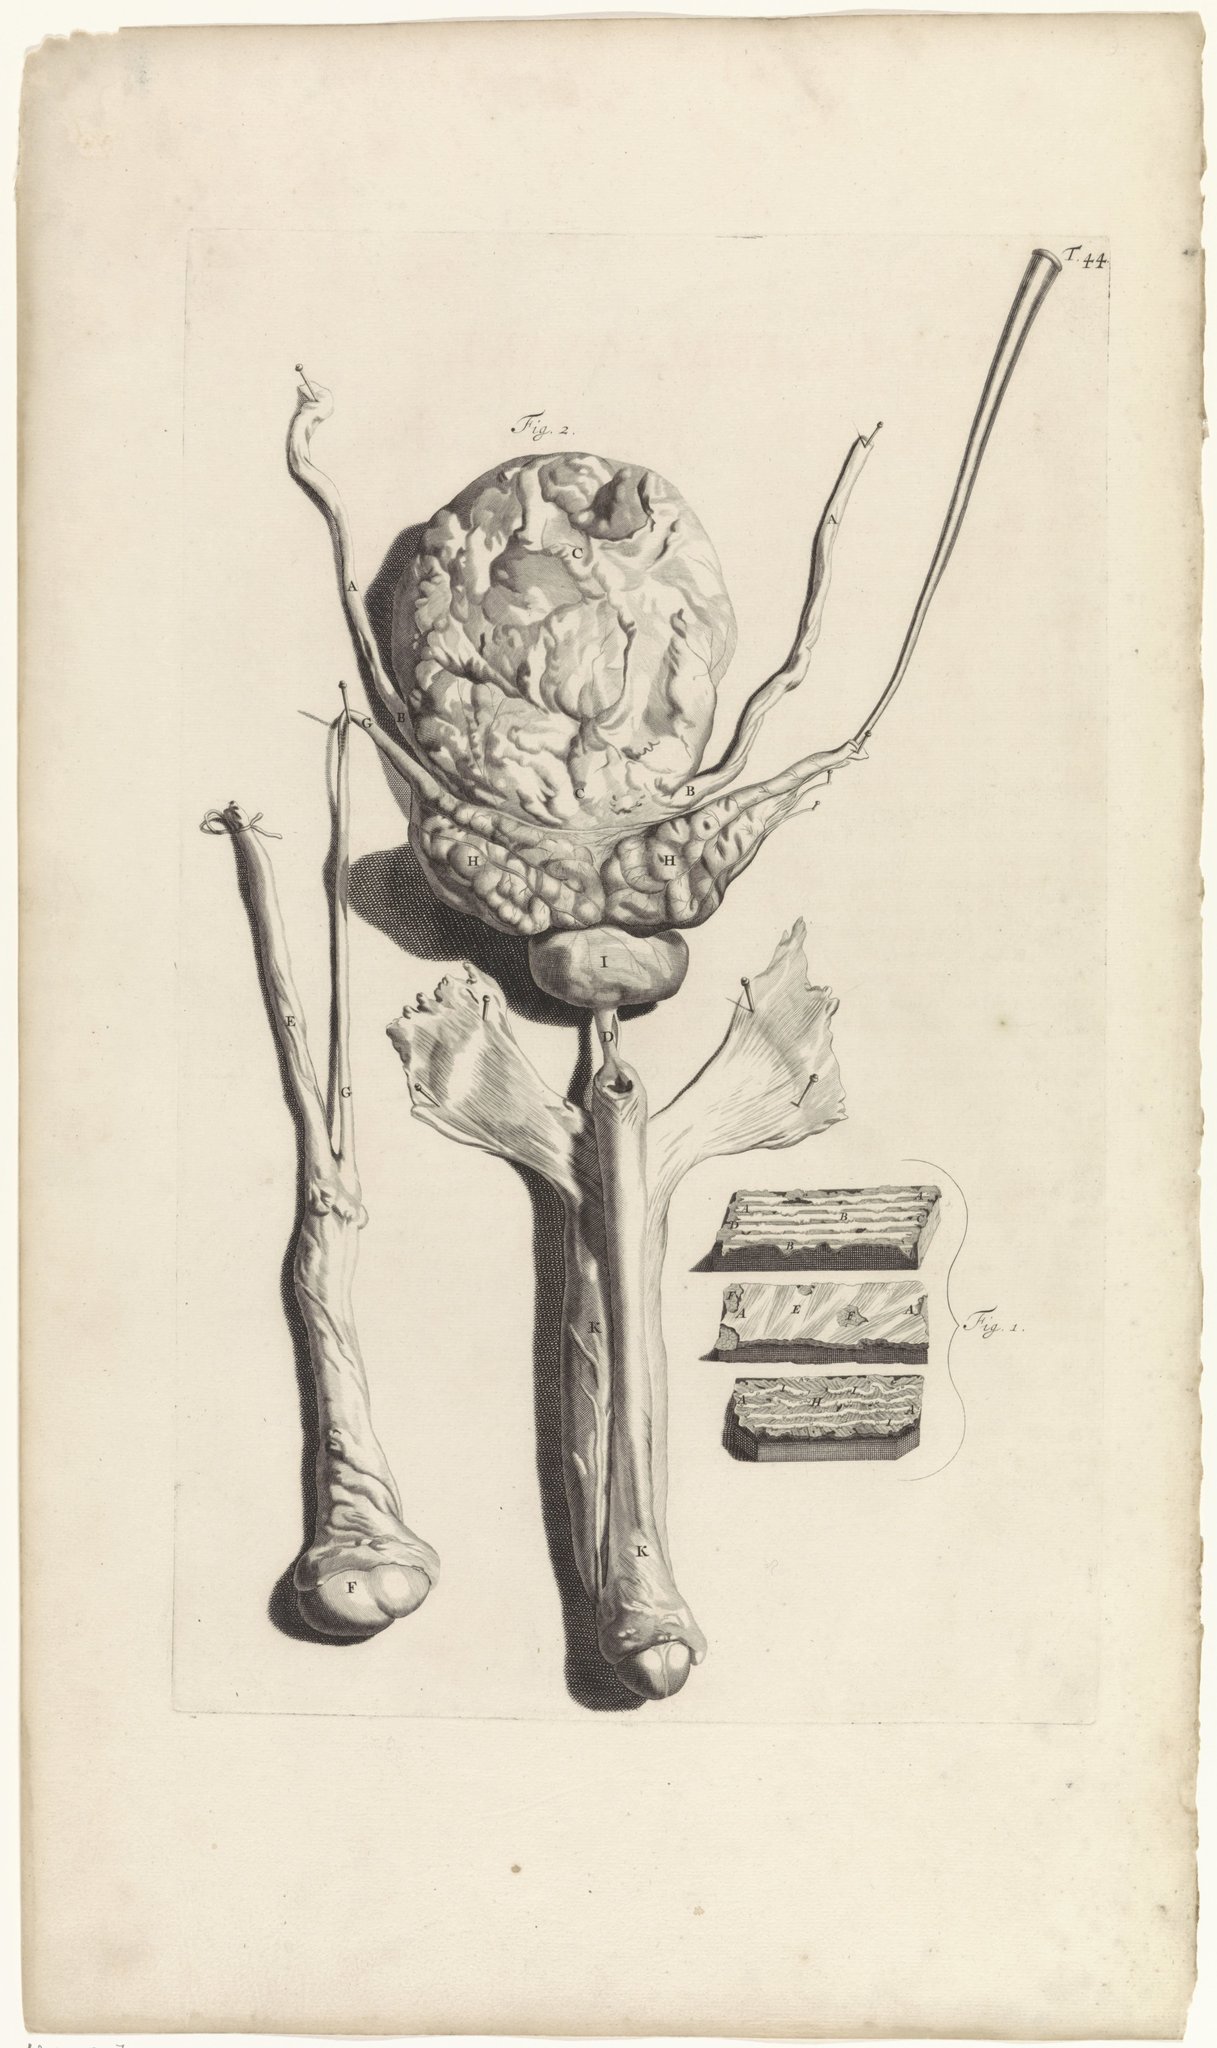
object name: print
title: Anatomische studie van het mannelijk voortplantingsstelsel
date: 1685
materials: paper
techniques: engraving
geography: amsterdam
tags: male sexual organs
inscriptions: collector's mark: Lugt 2228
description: Boekillustratie voor Bidloo, Godefridus. Anatomia humani corporis centum & quinque tabulis, per art. G. de Lairesse ad vivum delineatis, de monstrata, veterum recentiorumque inventis explicata plurimisque, hactenus non detectis, illustrata. Amsterdam: Weduwe Joannes van Someren, Hendrick Boom en erven Dirk Boom, 1685.